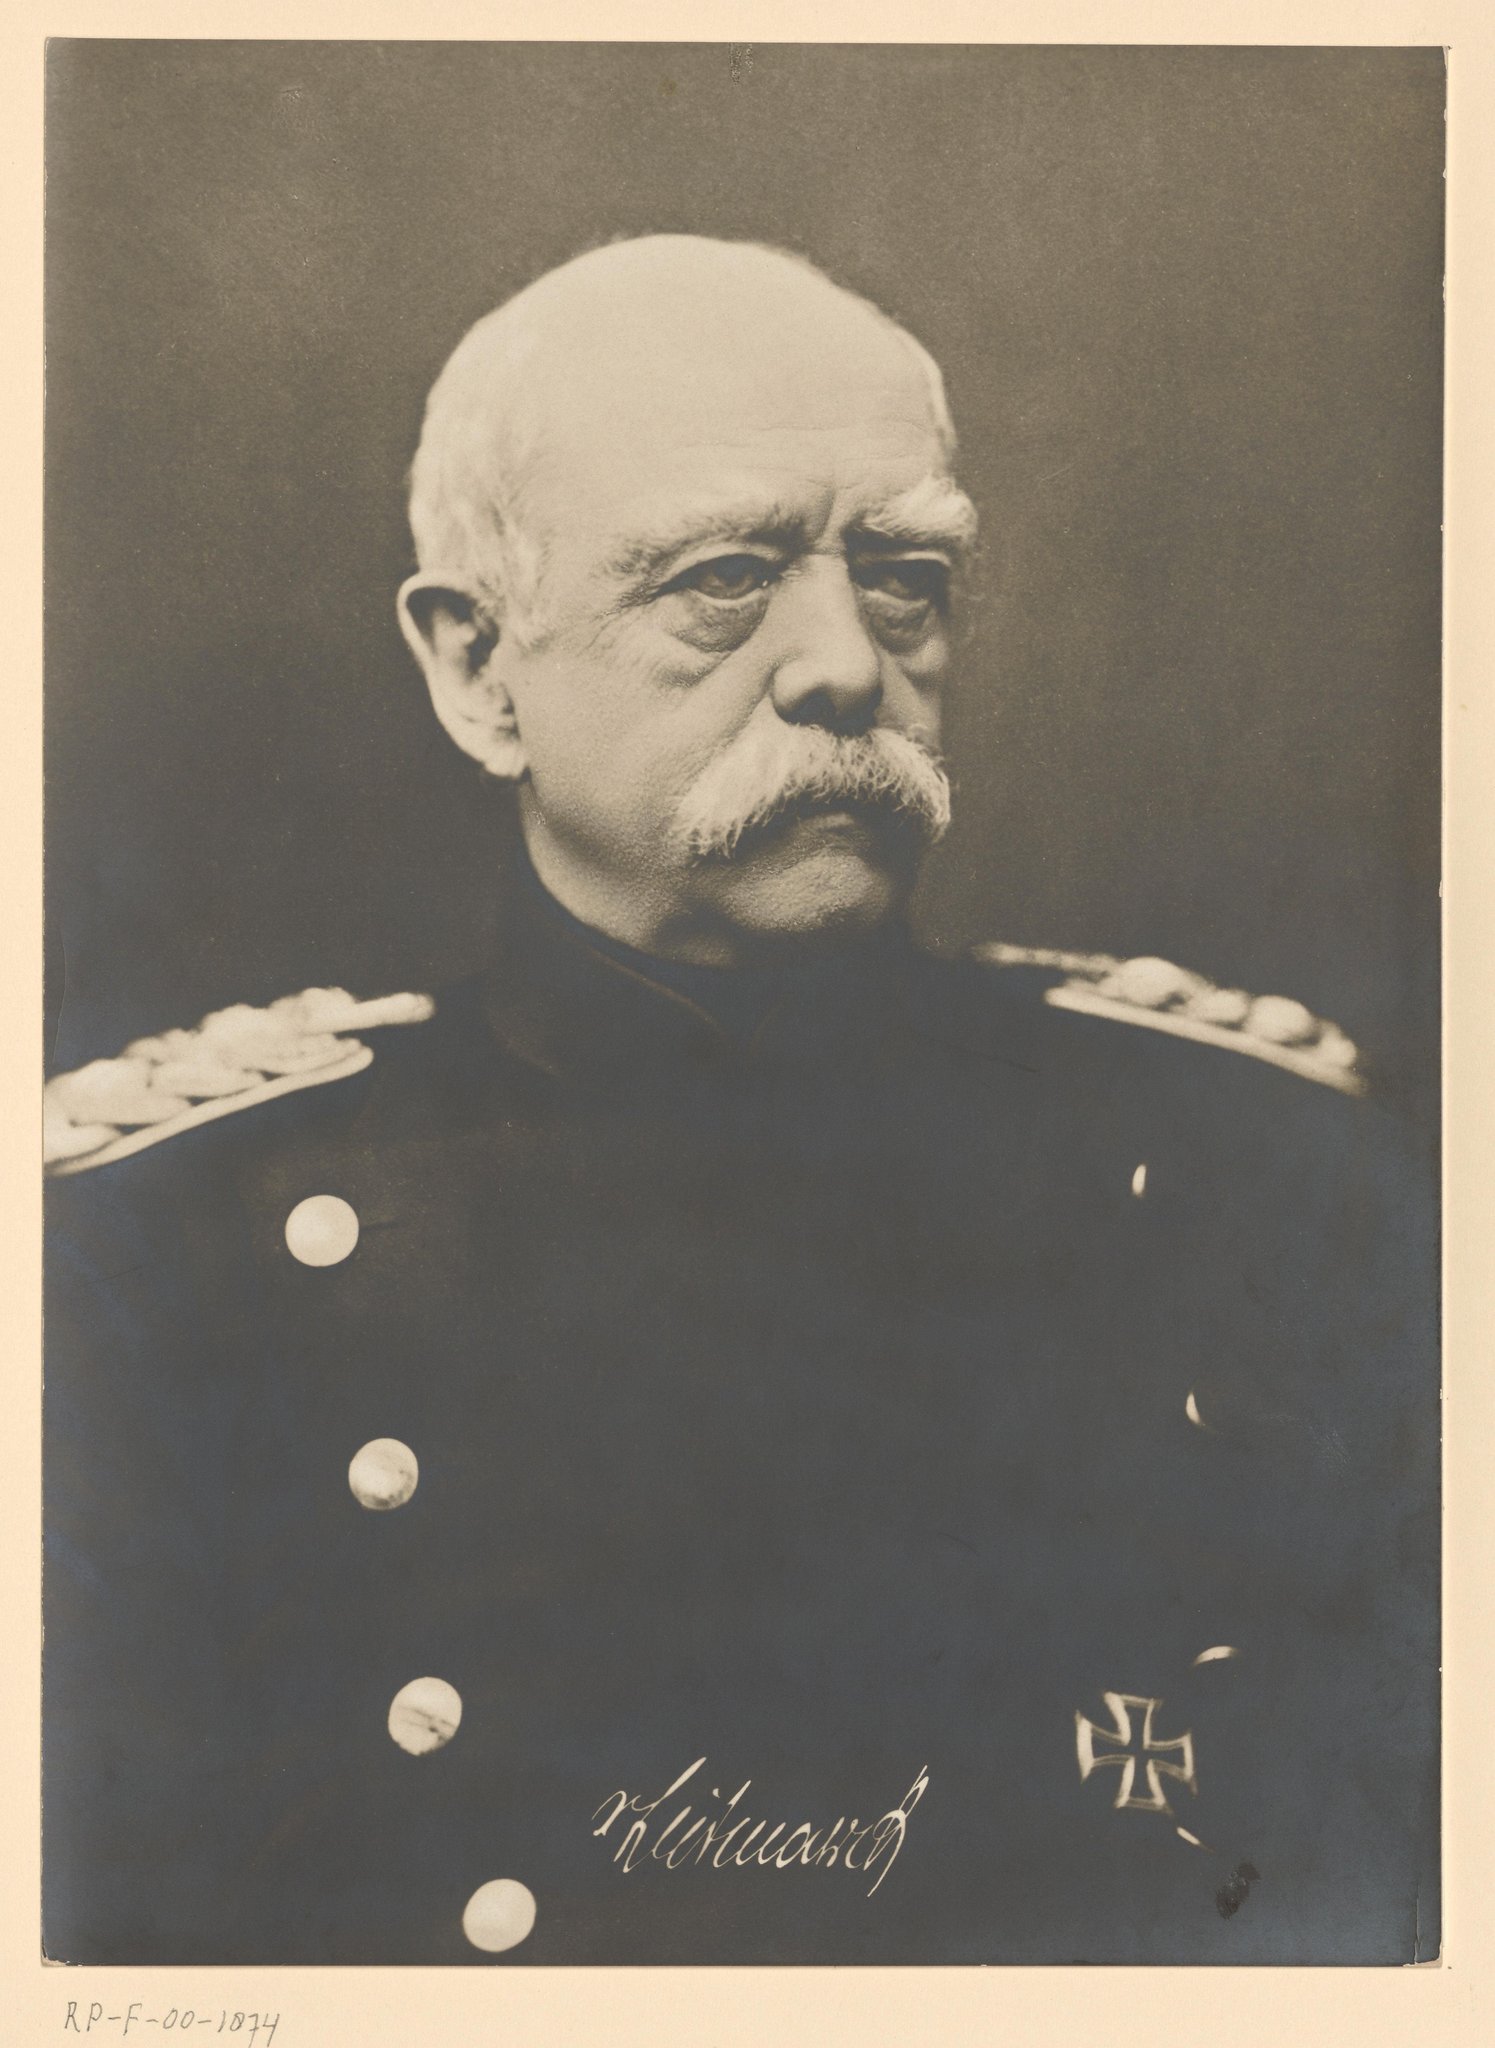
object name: photograph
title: Portret van Bismarck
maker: Anonymous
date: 1900-1920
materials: cardboard, paper, photographic support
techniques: gelatin silver print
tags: historical persons